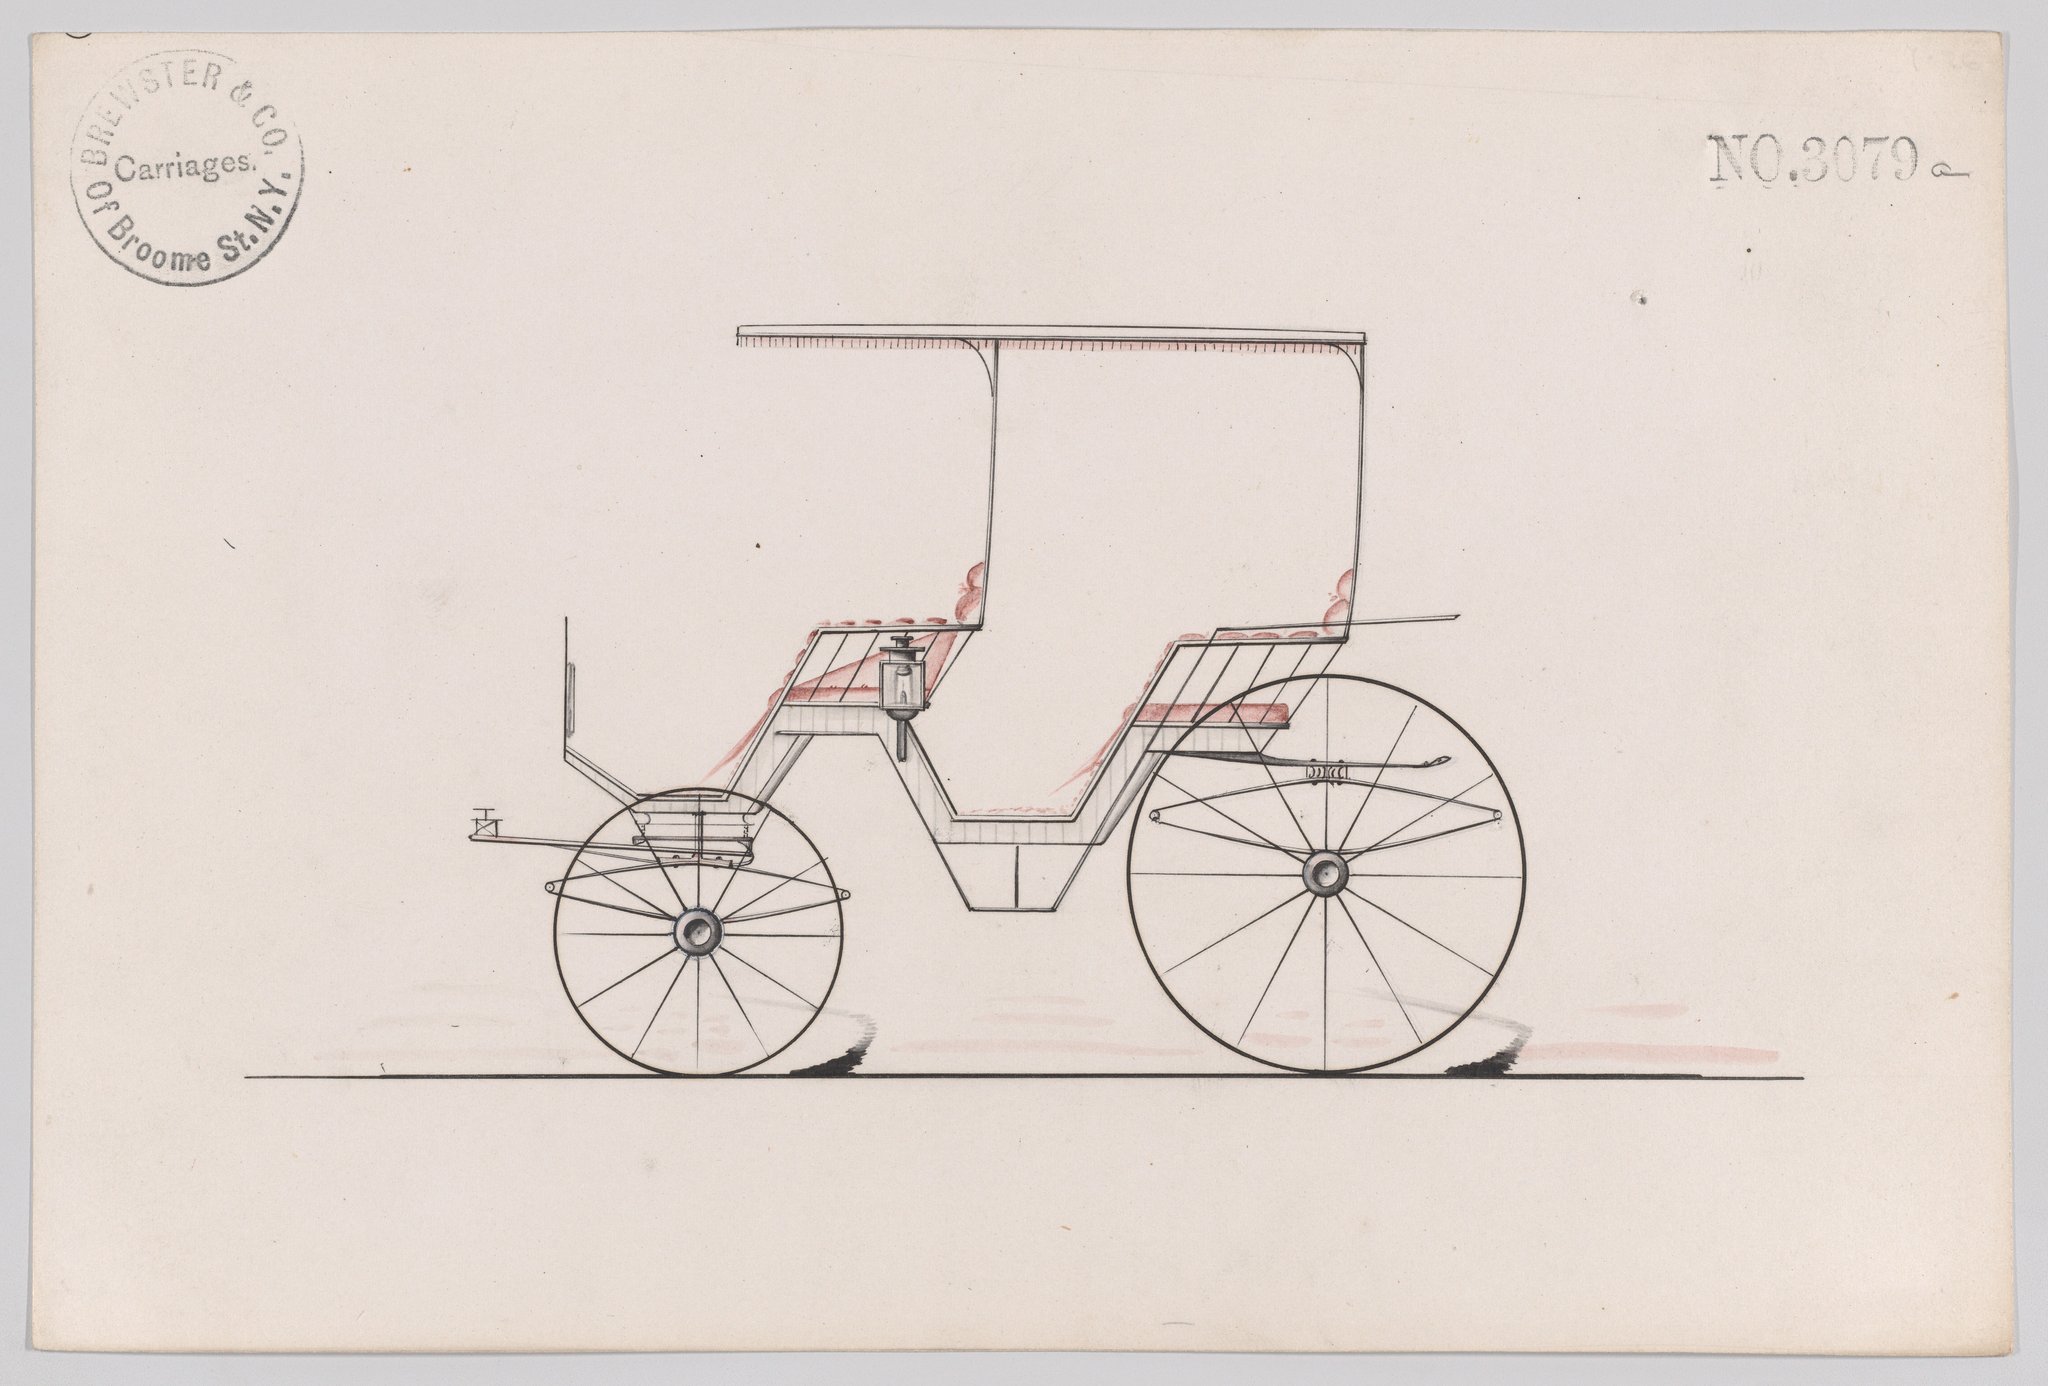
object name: drawing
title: Design for Canopy Top Phaeton, no. 3079a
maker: brewster & co.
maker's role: manufacturer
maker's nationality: american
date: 1874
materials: gouache, graphite, ink, watercolor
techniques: pen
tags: carriages